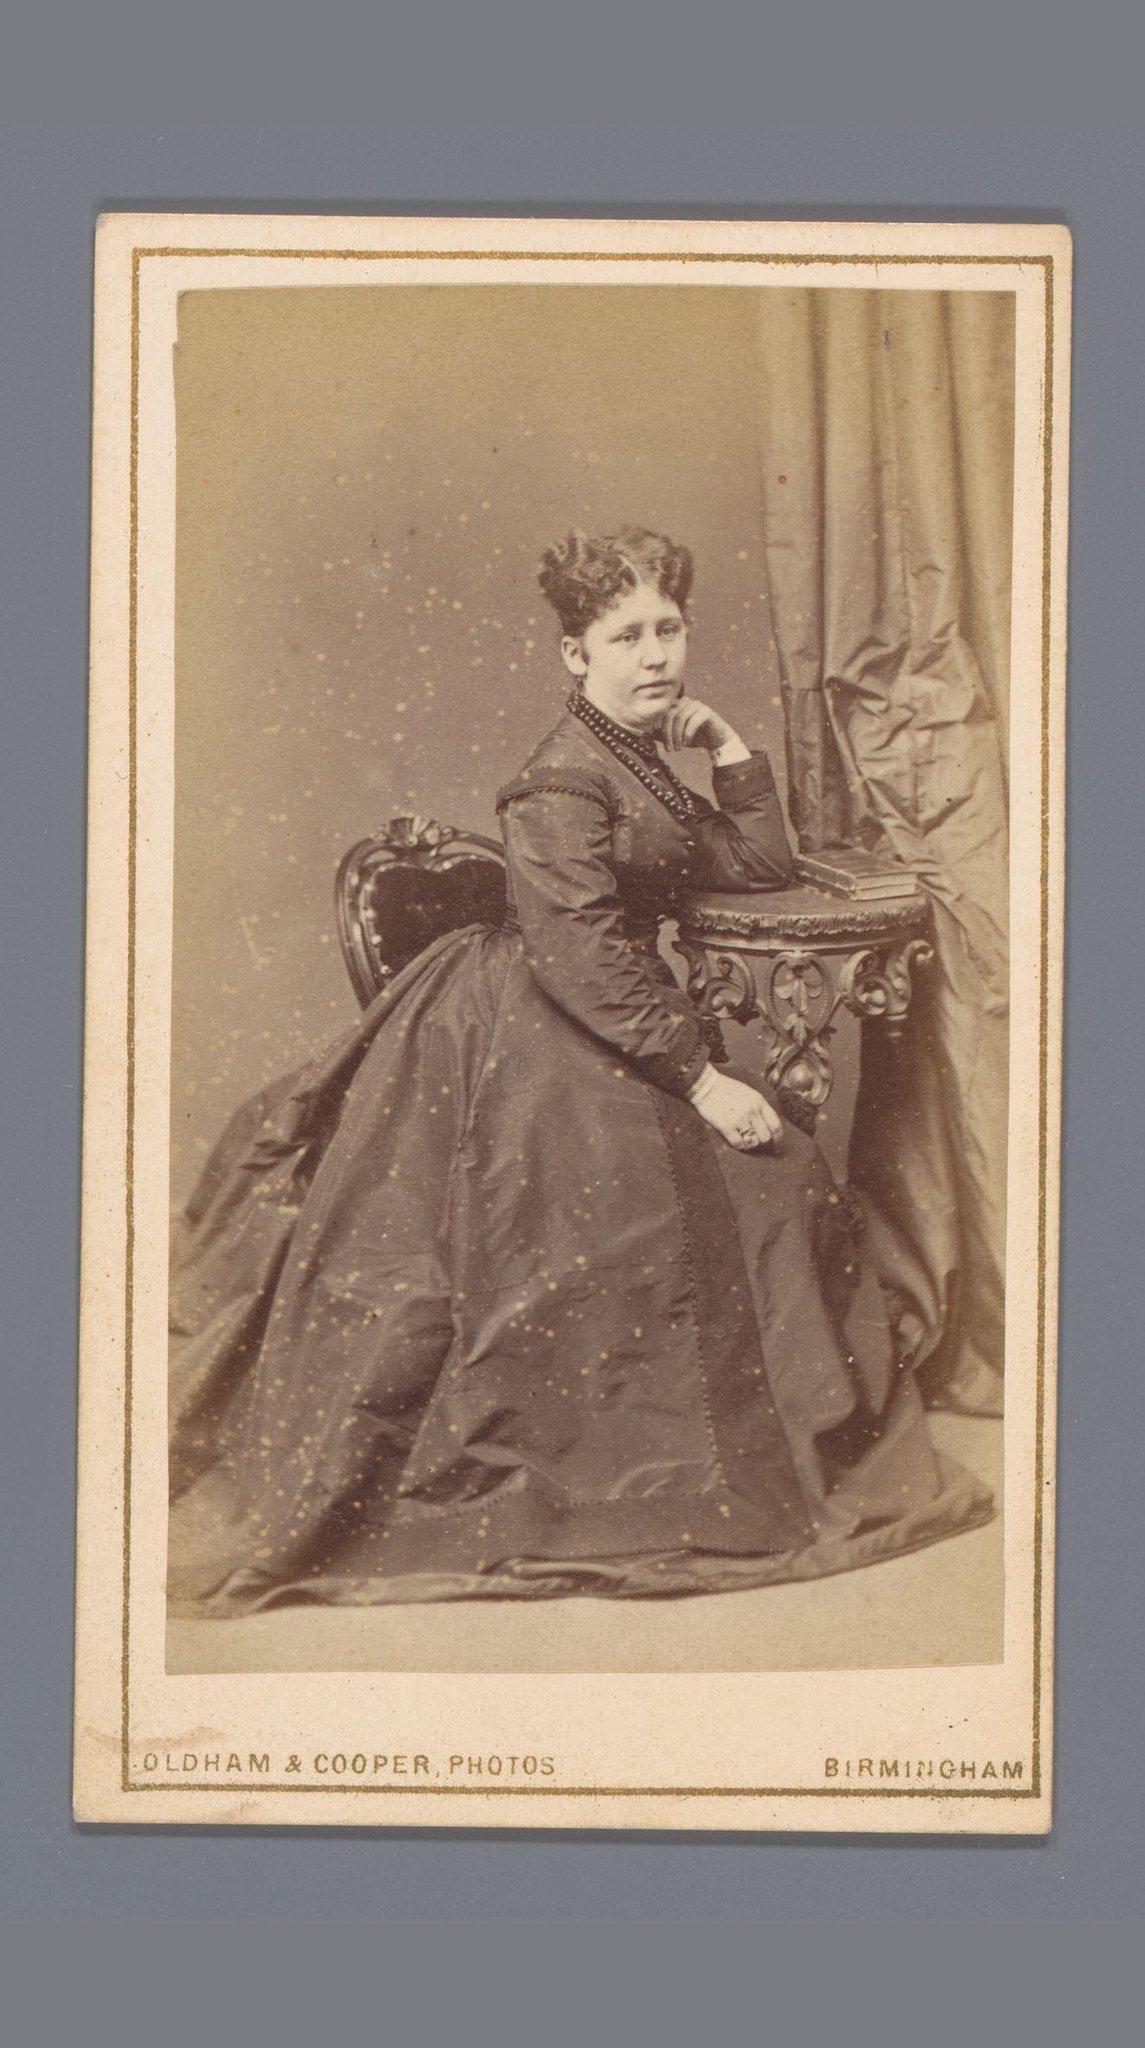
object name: carte de visite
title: Portret van een onbekende zittende vrouw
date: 1860-1870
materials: cardboard, paper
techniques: albumen print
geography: birmingham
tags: adult woman, anonymous historical person portrayed, birmingham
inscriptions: inscription: ‘Oldham & Cooper,/ Photographers,/ City Chambers/ &/ Town Hall Chambers/ 82 & 86, New Street/ Birmingham/ Copies may be had/ Copyright Marion Déposé’, inscription: ‘Oldham & Cooper Photos Birmingham’